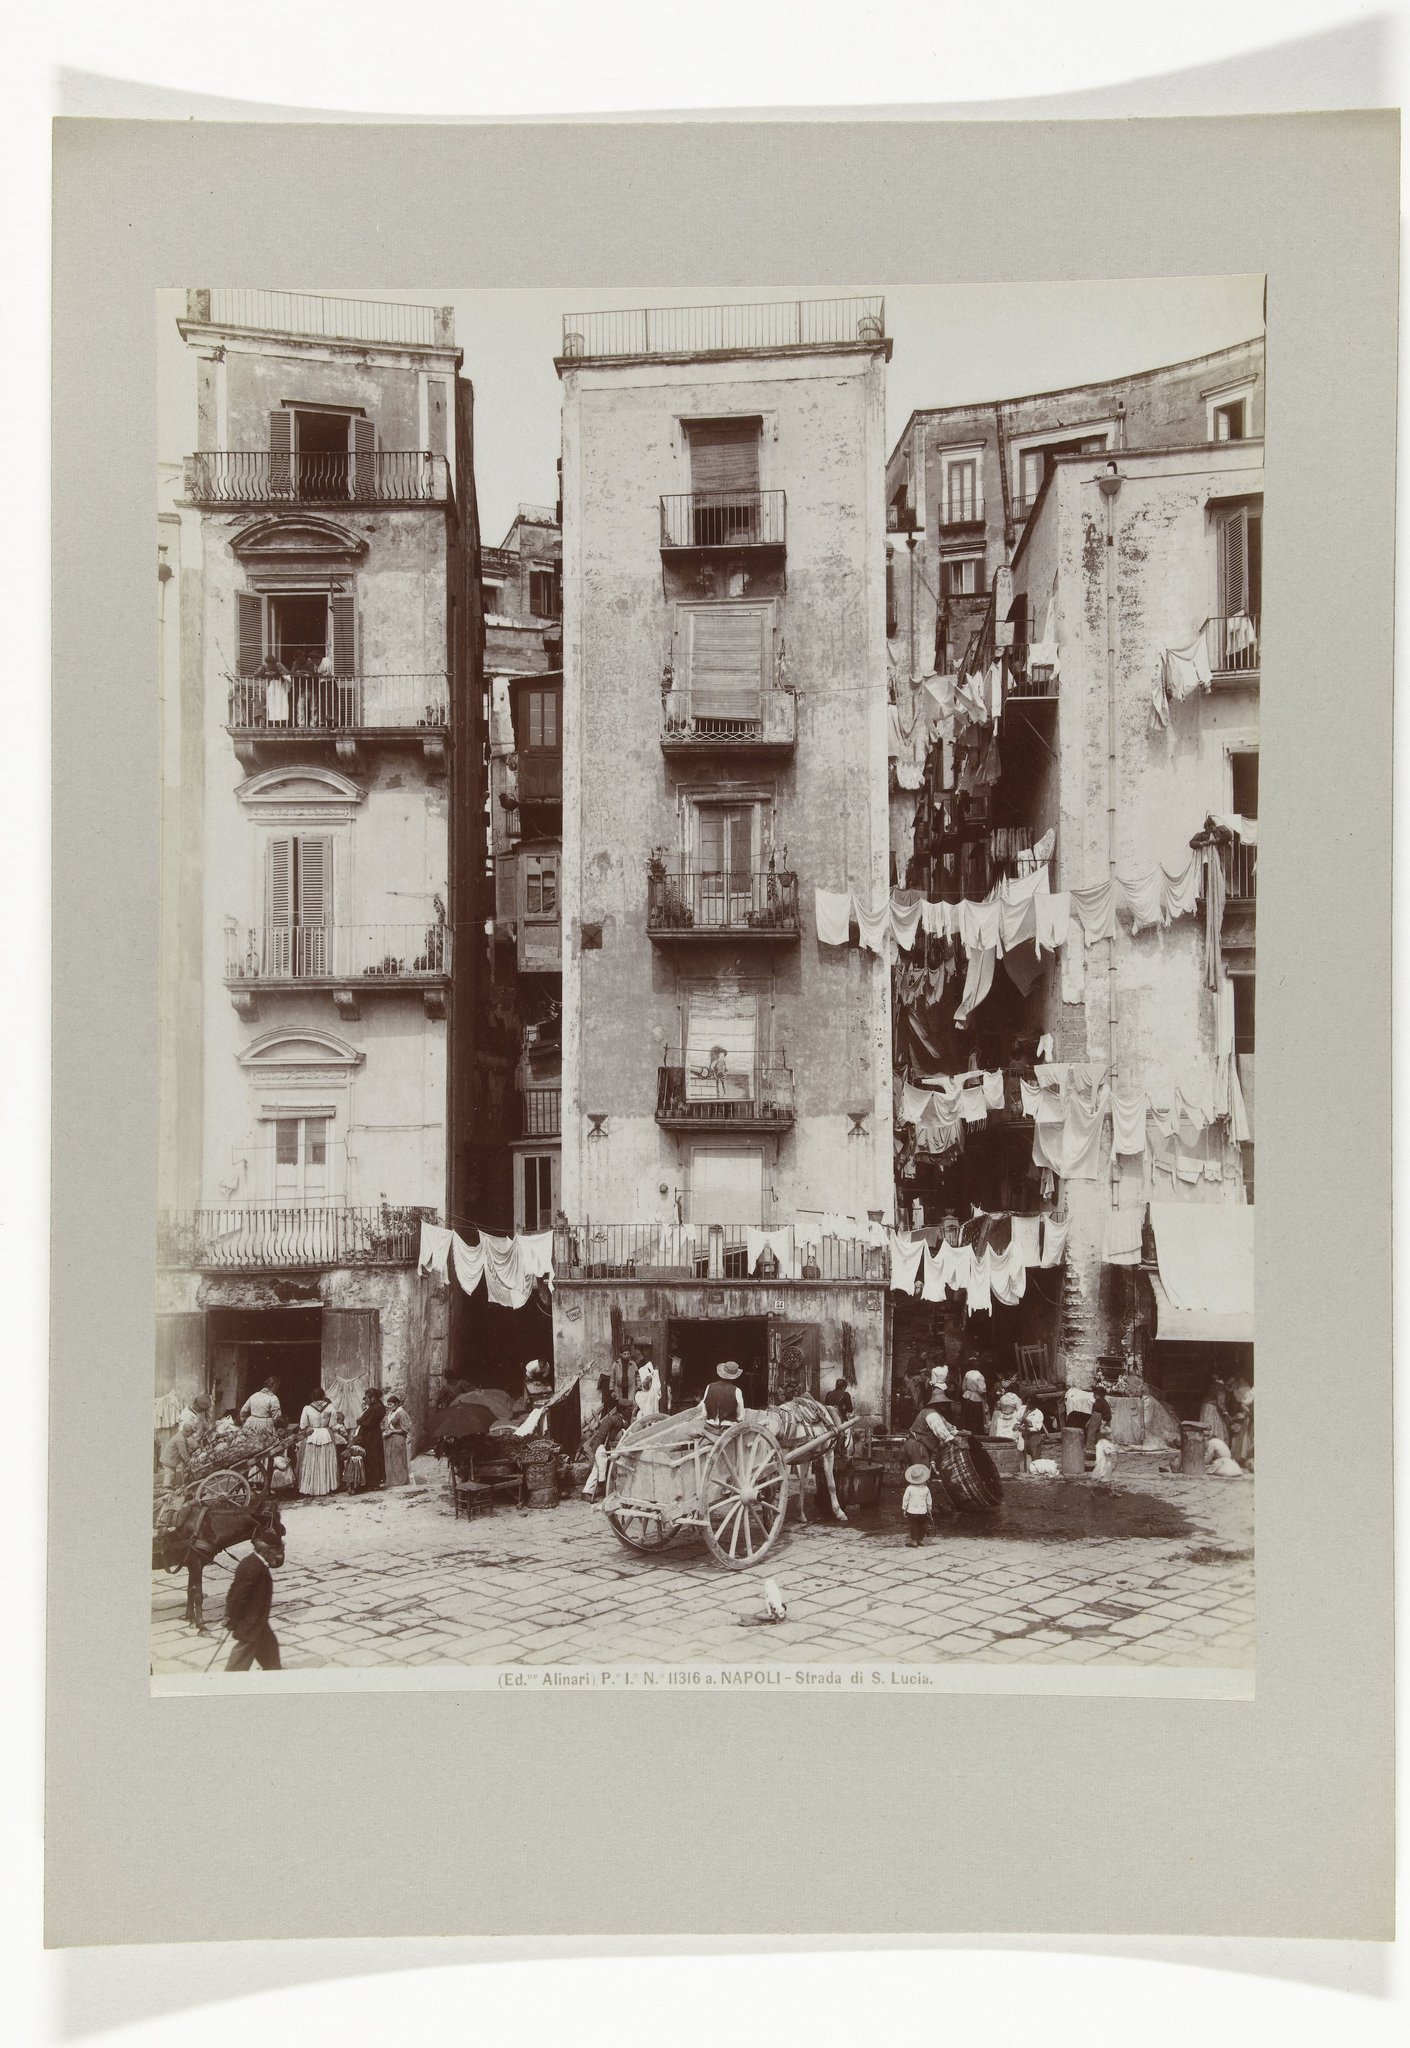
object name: photograph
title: Strada di Santa Lucia in Napels met mensen op straat en drogend wasgoed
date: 1880-1895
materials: cardboard, paper, photographic support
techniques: albumen print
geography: florence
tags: street, naples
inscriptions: number: ‘53.’